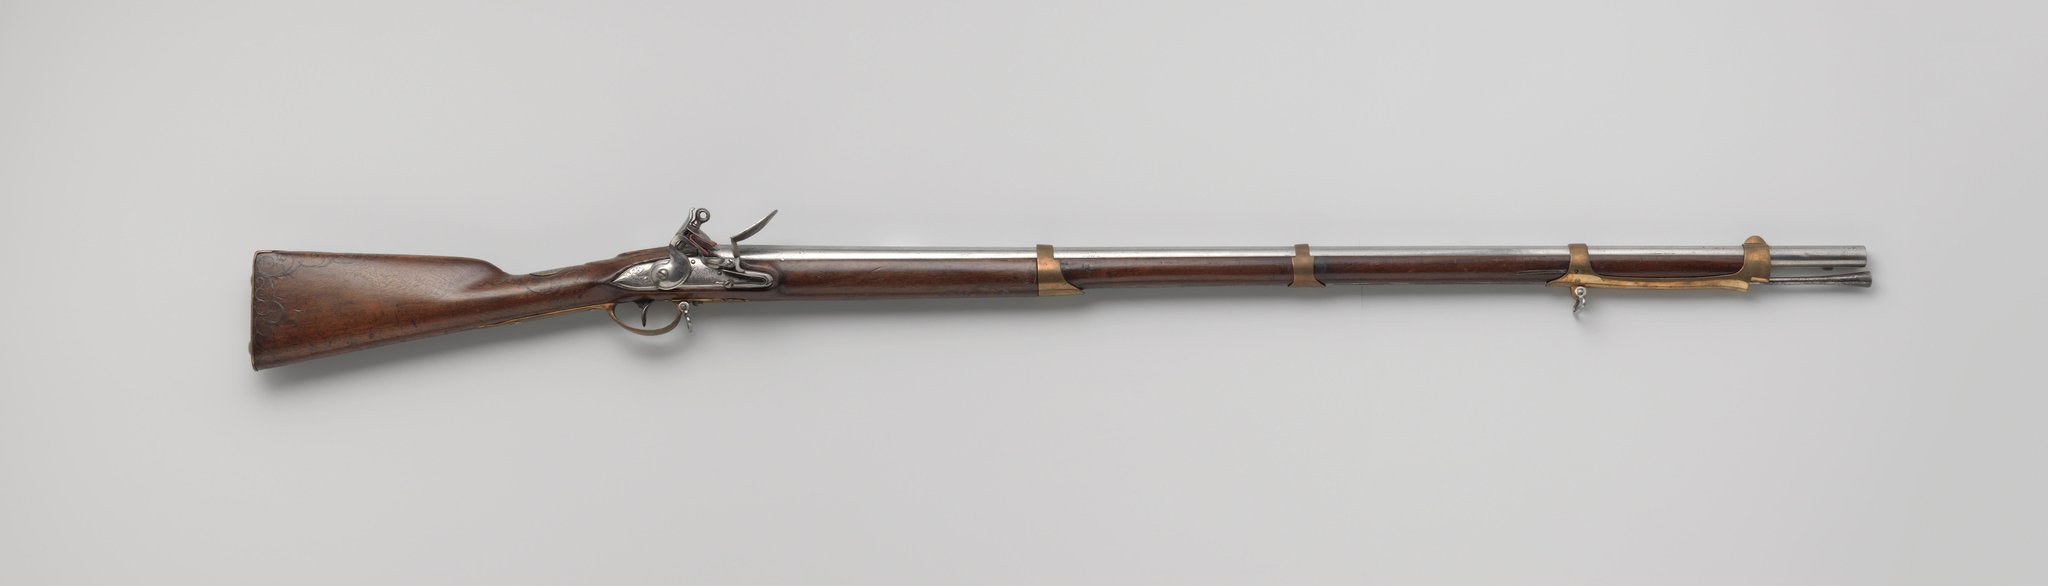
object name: flintlock pistol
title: Officiersvuursteengeweer voor leger of schutterij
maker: hendrick brandt (geweermaker)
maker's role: geweermaker, pistoolmaker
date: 1790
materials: brass, iron, silver, thread, steel, wood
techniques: printing, engraving, gilding, inlay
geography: amsterdam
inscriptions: signature: ‘H. Brandt // Amsterdam’, mark: ‘MR; P en een niet te identificeren merk’, coat of arms: ‘wapen van Amsterdam’, monogram: ‘IF’